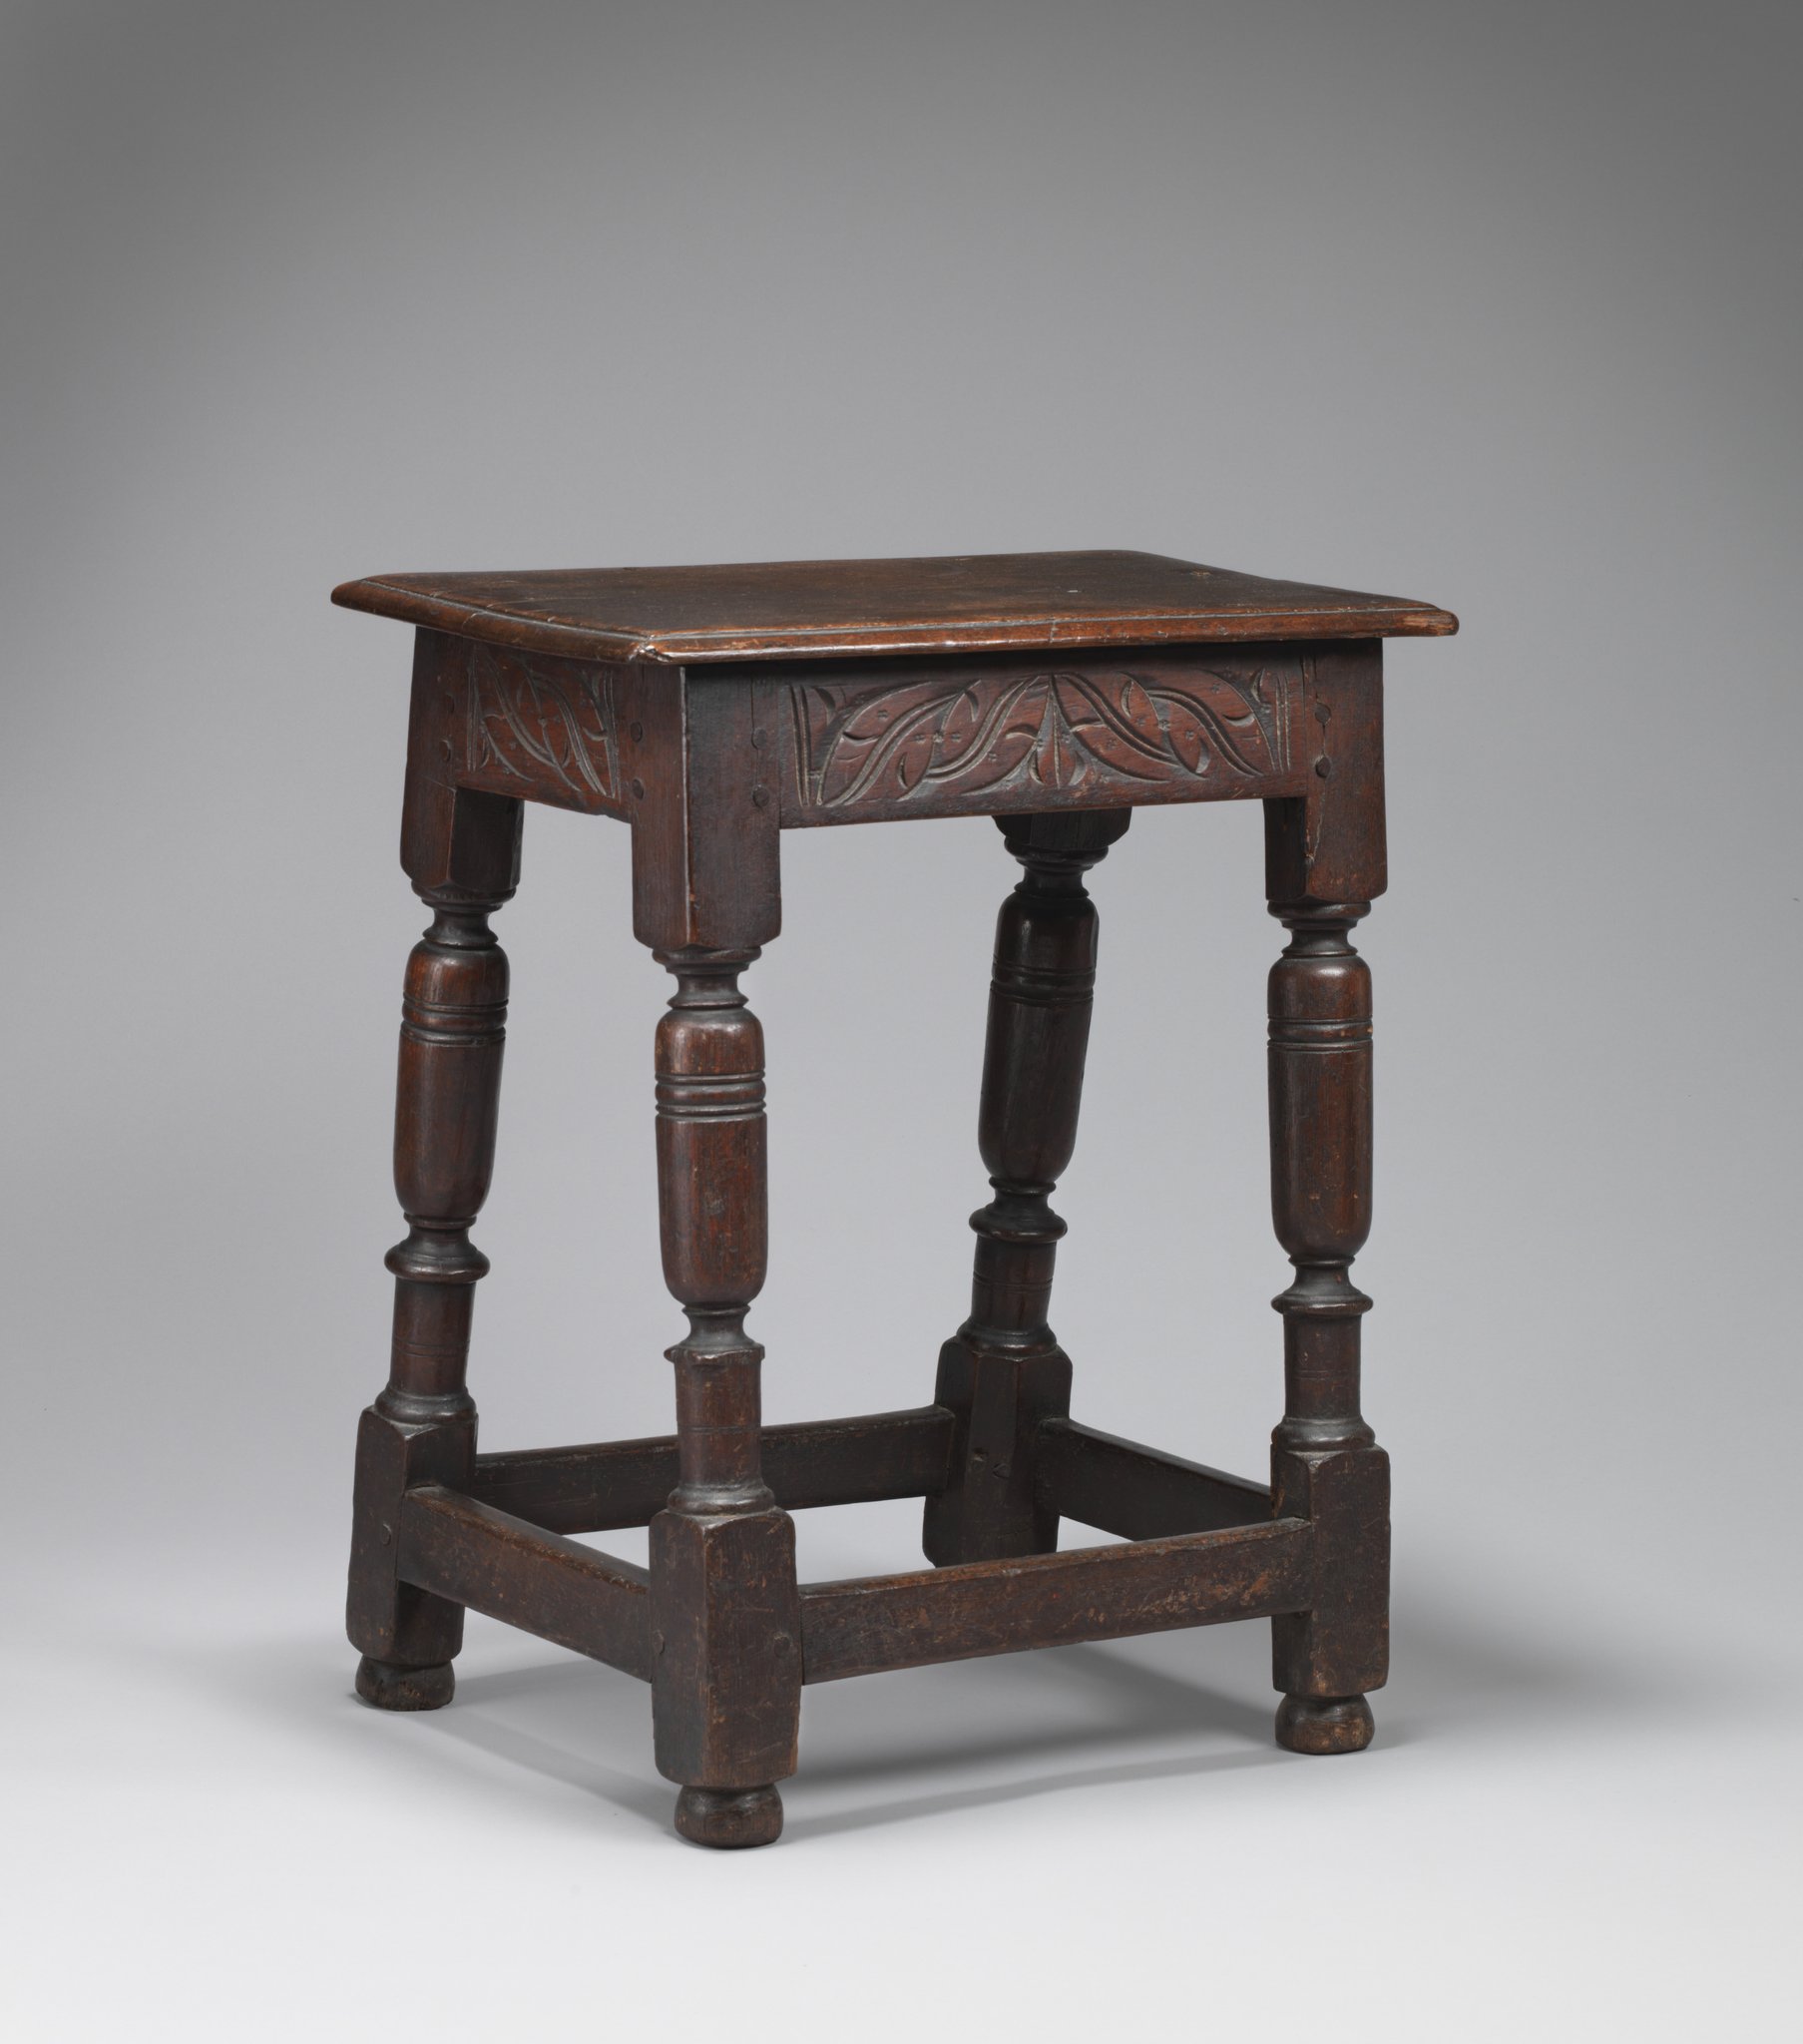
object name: stool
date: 1625-1640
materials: wood